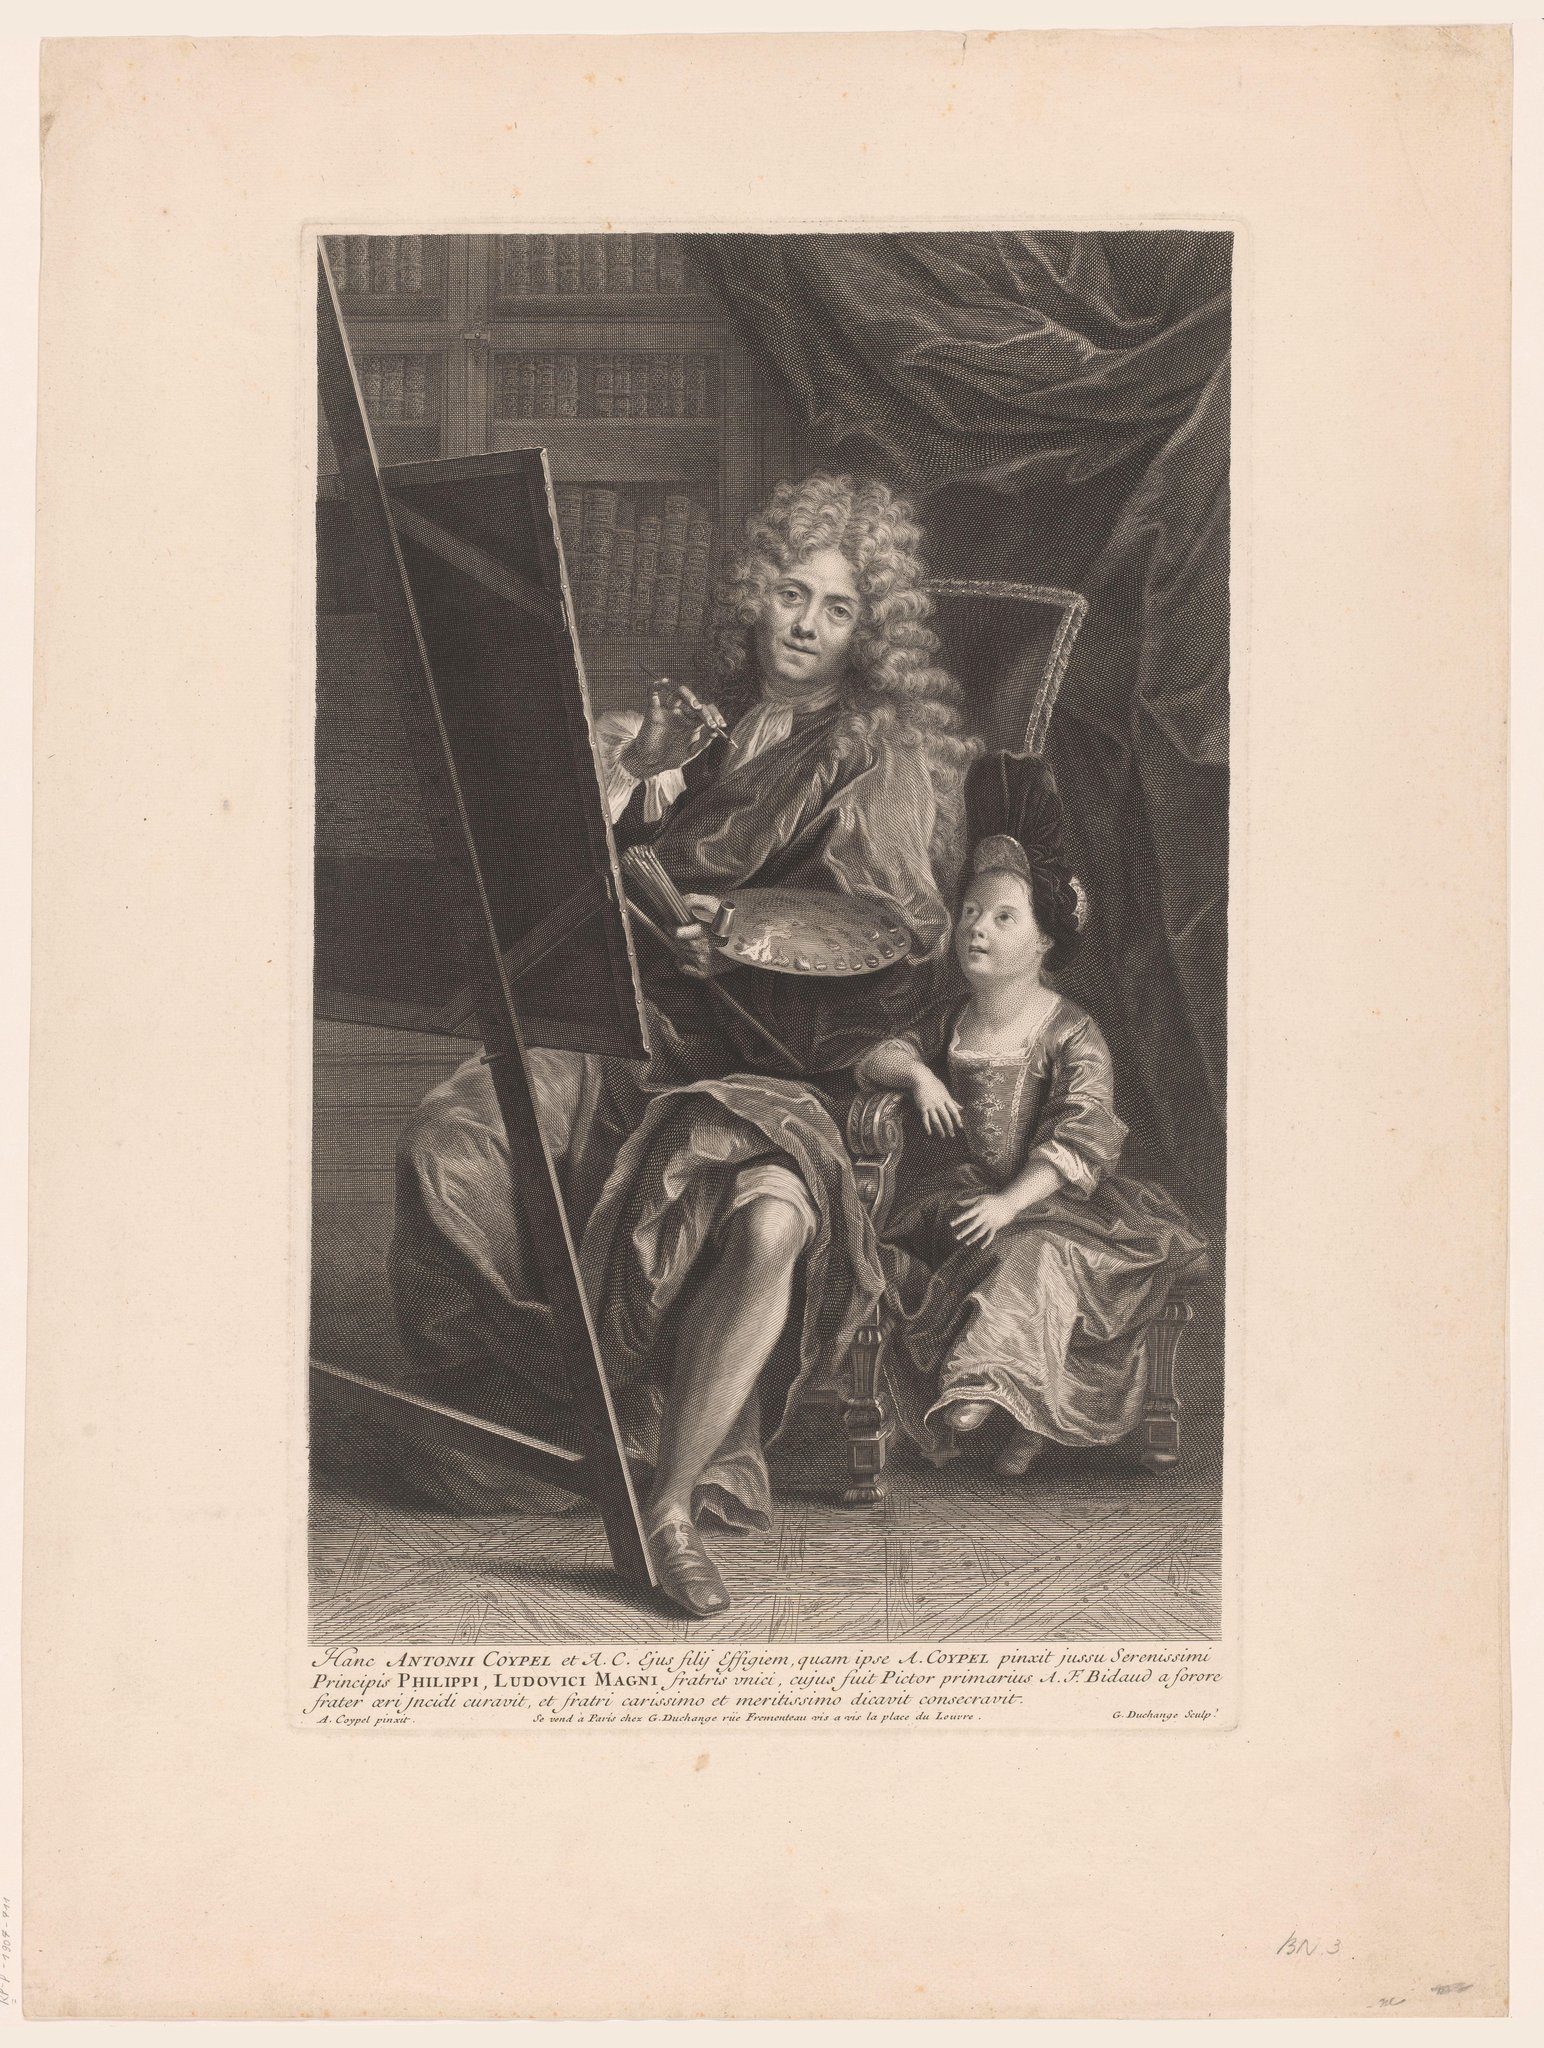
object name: print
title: Antoine Coypel met zoon aan schildersezel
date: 1702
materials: paper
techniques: engraving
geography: paris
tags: paris, draughtsman, antoine coypel, portrait, self-portrait of painter, easel, father and son(s) (family group)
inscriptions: collector's mark: Lugt 2228